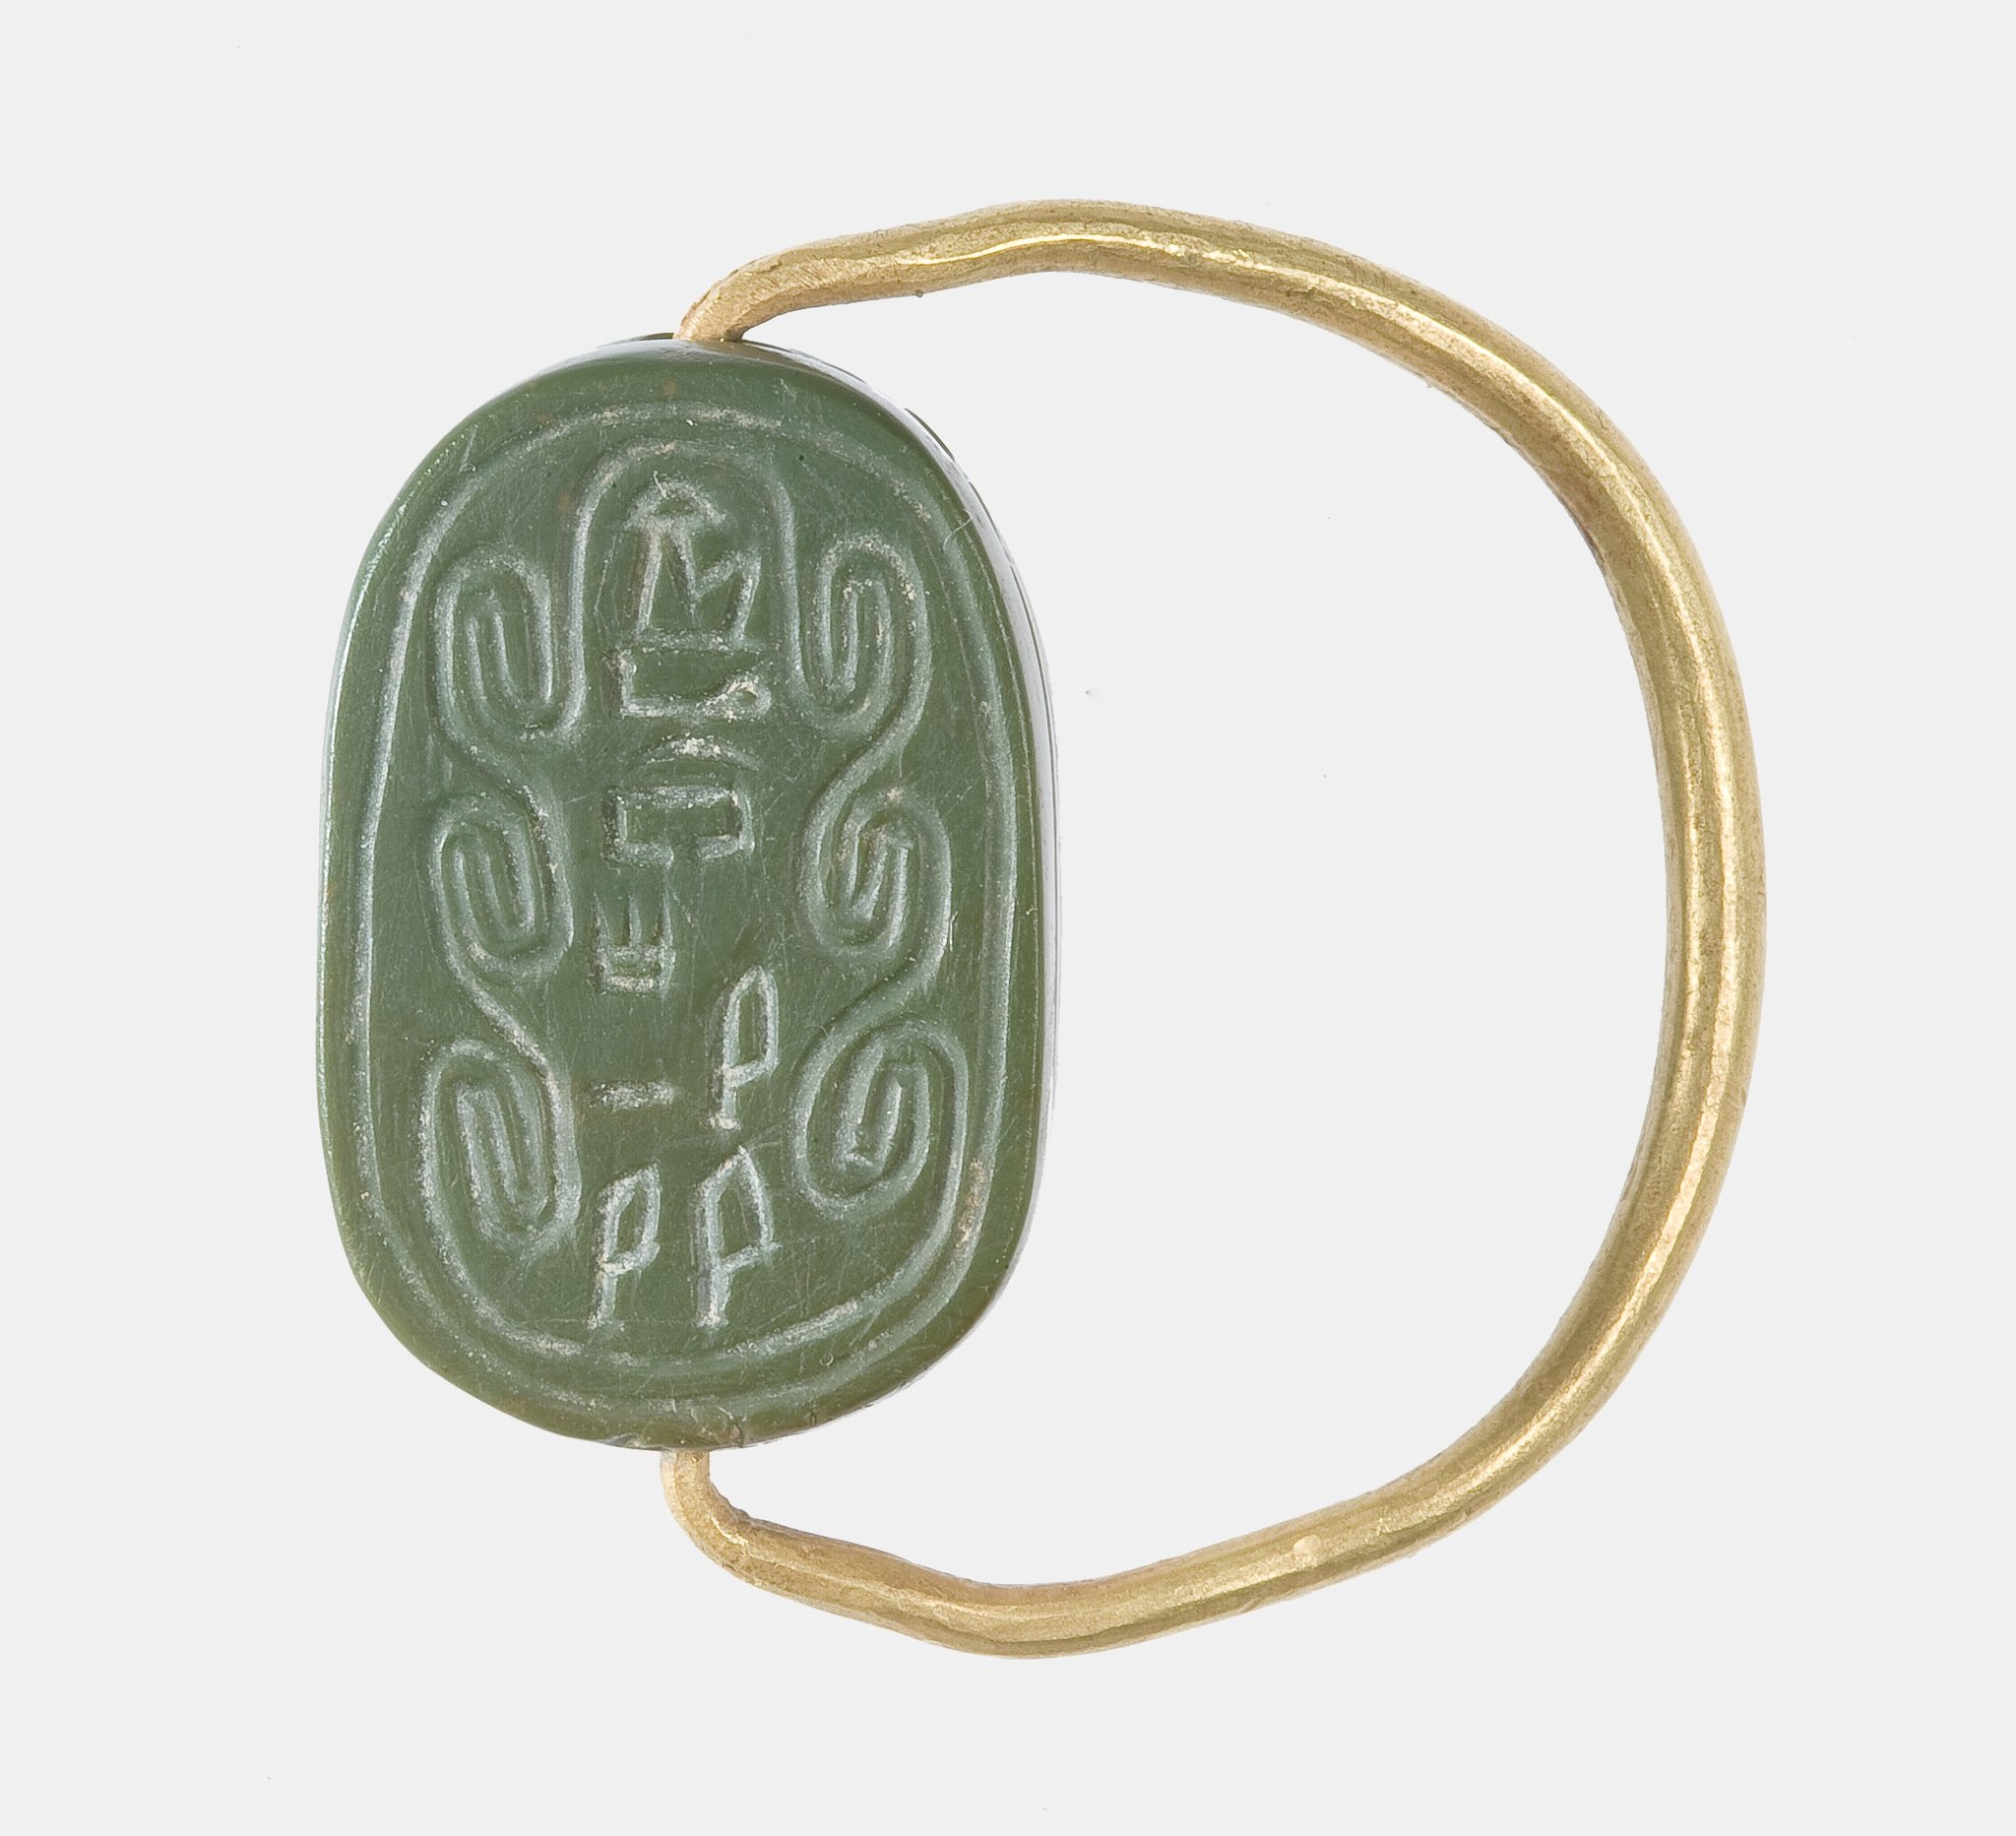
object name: ring, scarab, ameny, private name and title, official, scroll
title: Scarab Finger Ring of an Official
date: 1802-1640 BCE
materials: jasper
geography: egypt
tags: hieroglyphs,scarabs